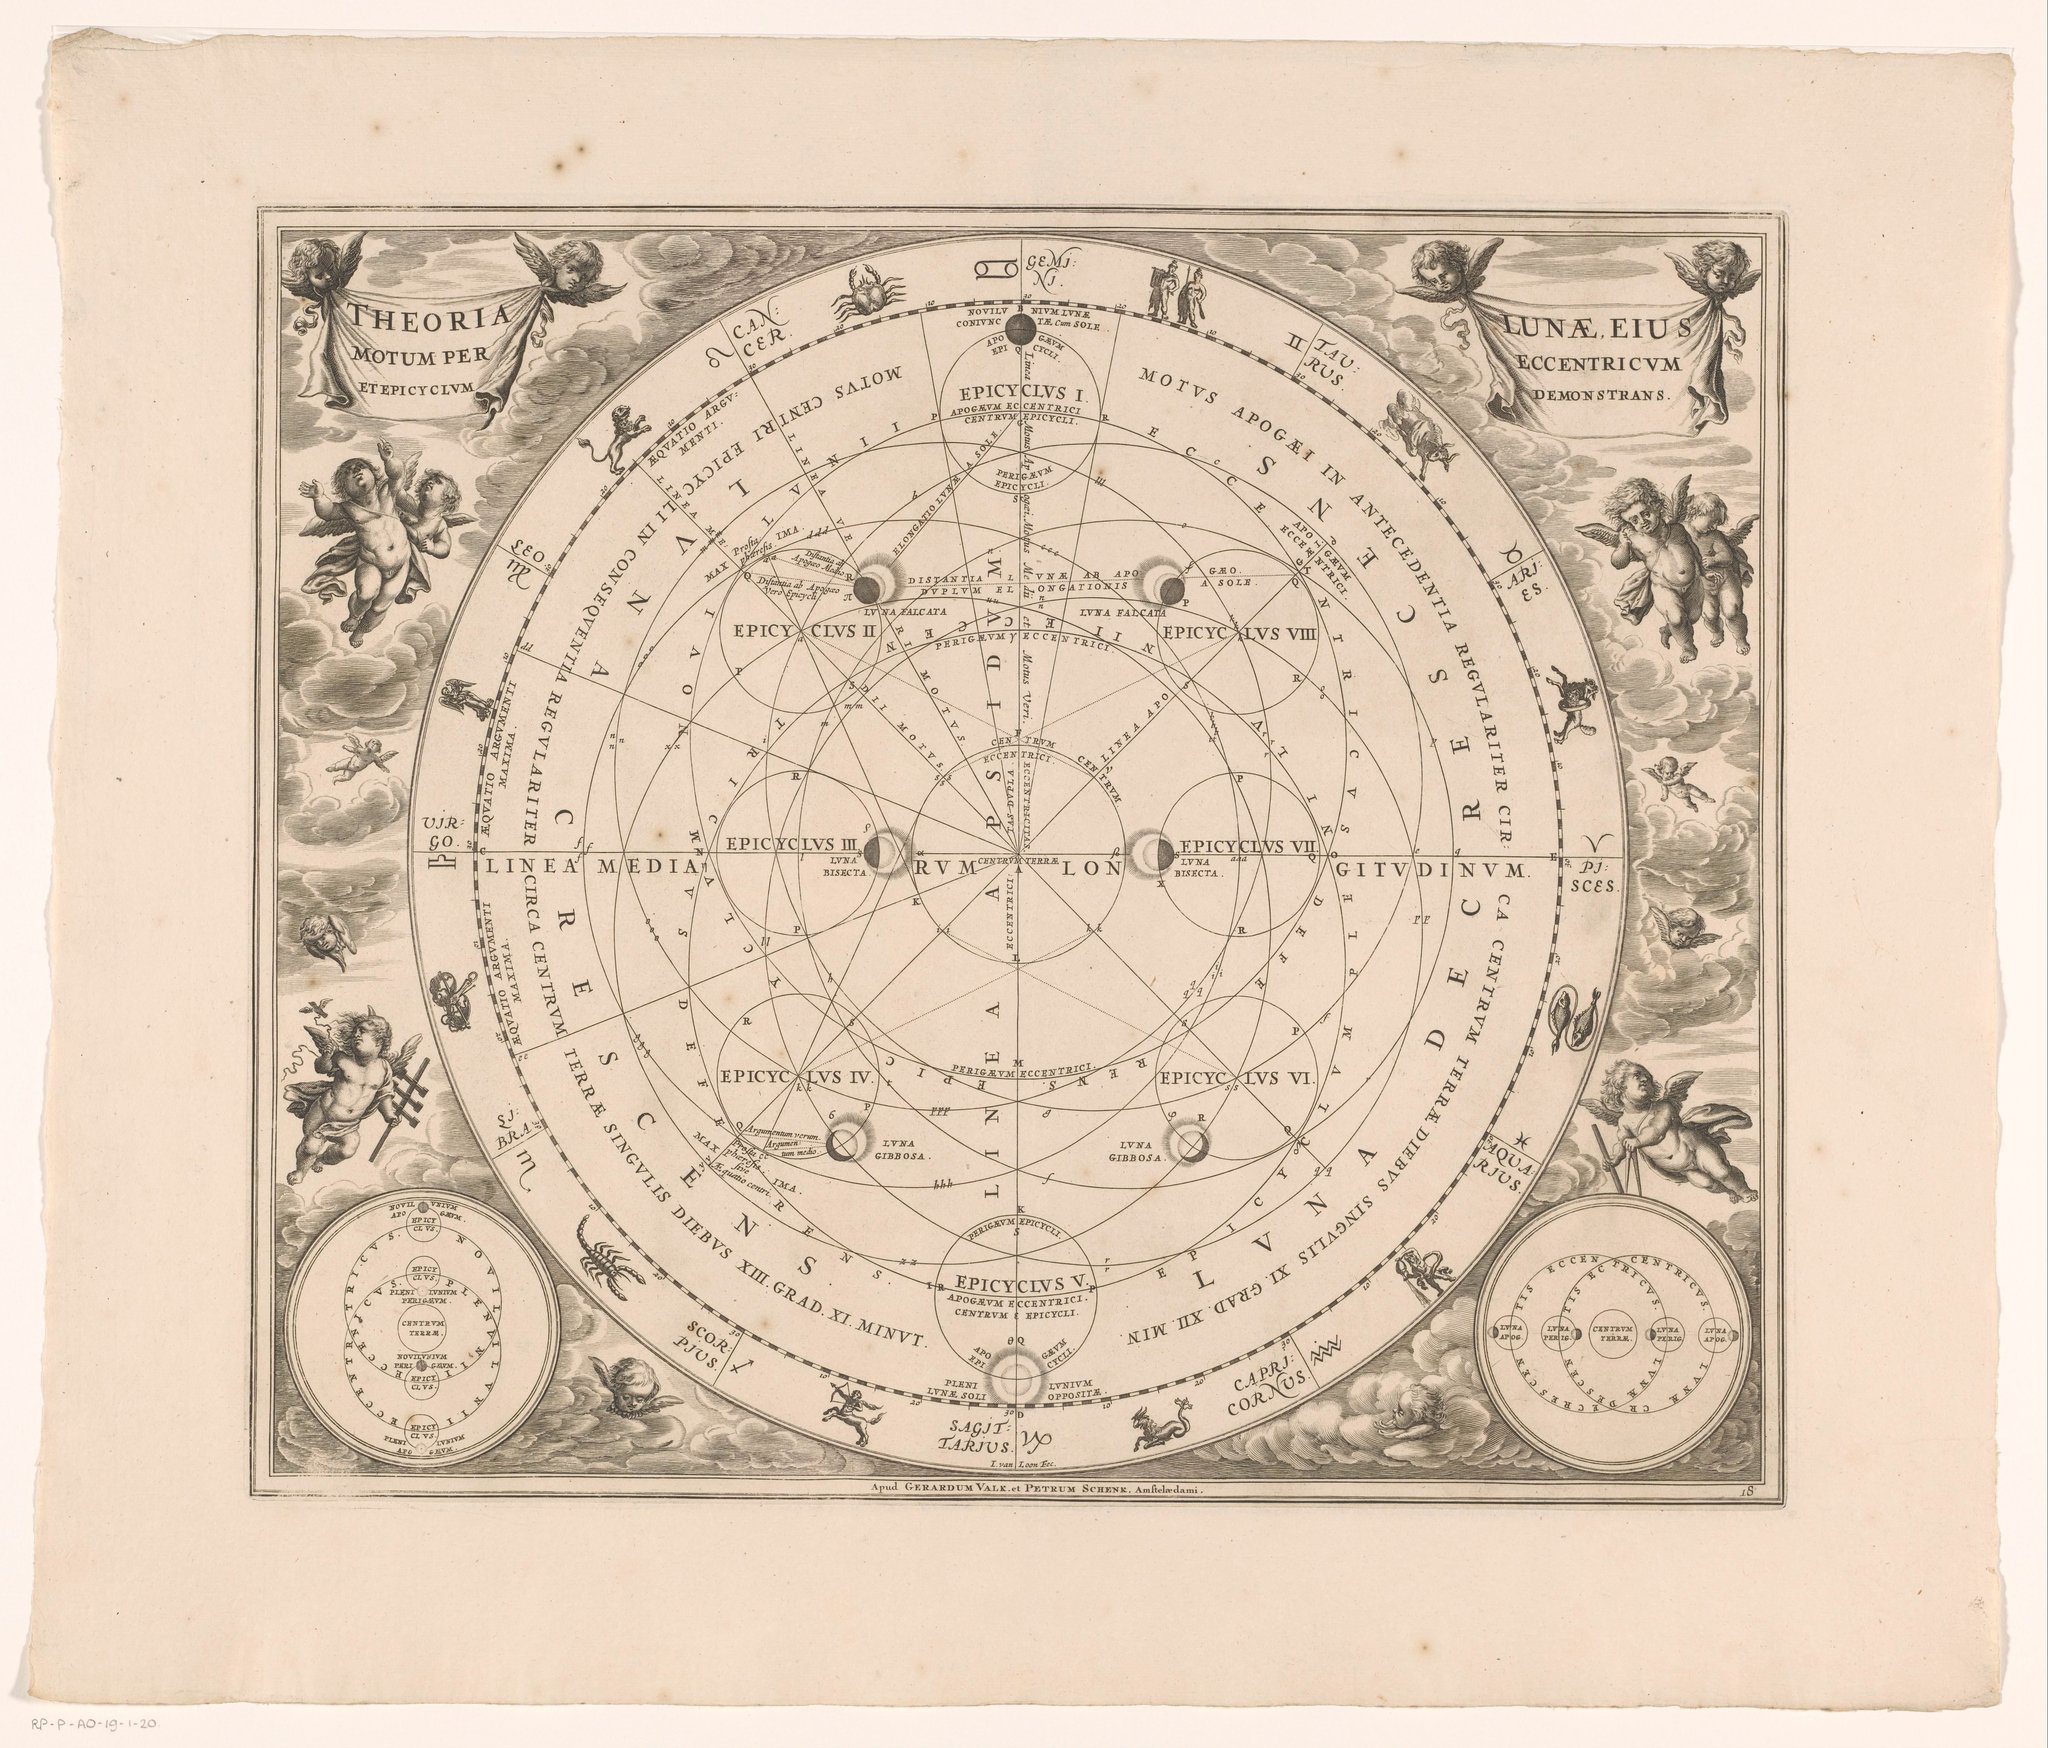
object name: map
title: Theoria Lunae, eius motum per eccentricum et epicyclum demonstrans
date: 1660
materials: paper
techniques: engraving, etching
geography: amsterdam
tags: zodiac; the twelve zodiacal signs together, moon as celestial body, star-chart, star map, planets; planetary system, solar system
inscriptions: collector's mark: Lugt 2228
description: Hemelkaart van de baan van de maan rond de aarde, volgens het stelsel van Ptolemaeus. Op de kaart zijn de schijngestalten van de maan weergegeven. In de buitenste ring is de dierenriem te zien. De kaart is voorzien van een gradenverdeling langs de randen. Links- en rechtsboven de titelcartouches. Links- en rechtsonder bollen met versimpelde weergaven van de baan van de maan volgens het stelsel van Ptolemaeus. Rechtsonder genummerd: 18.